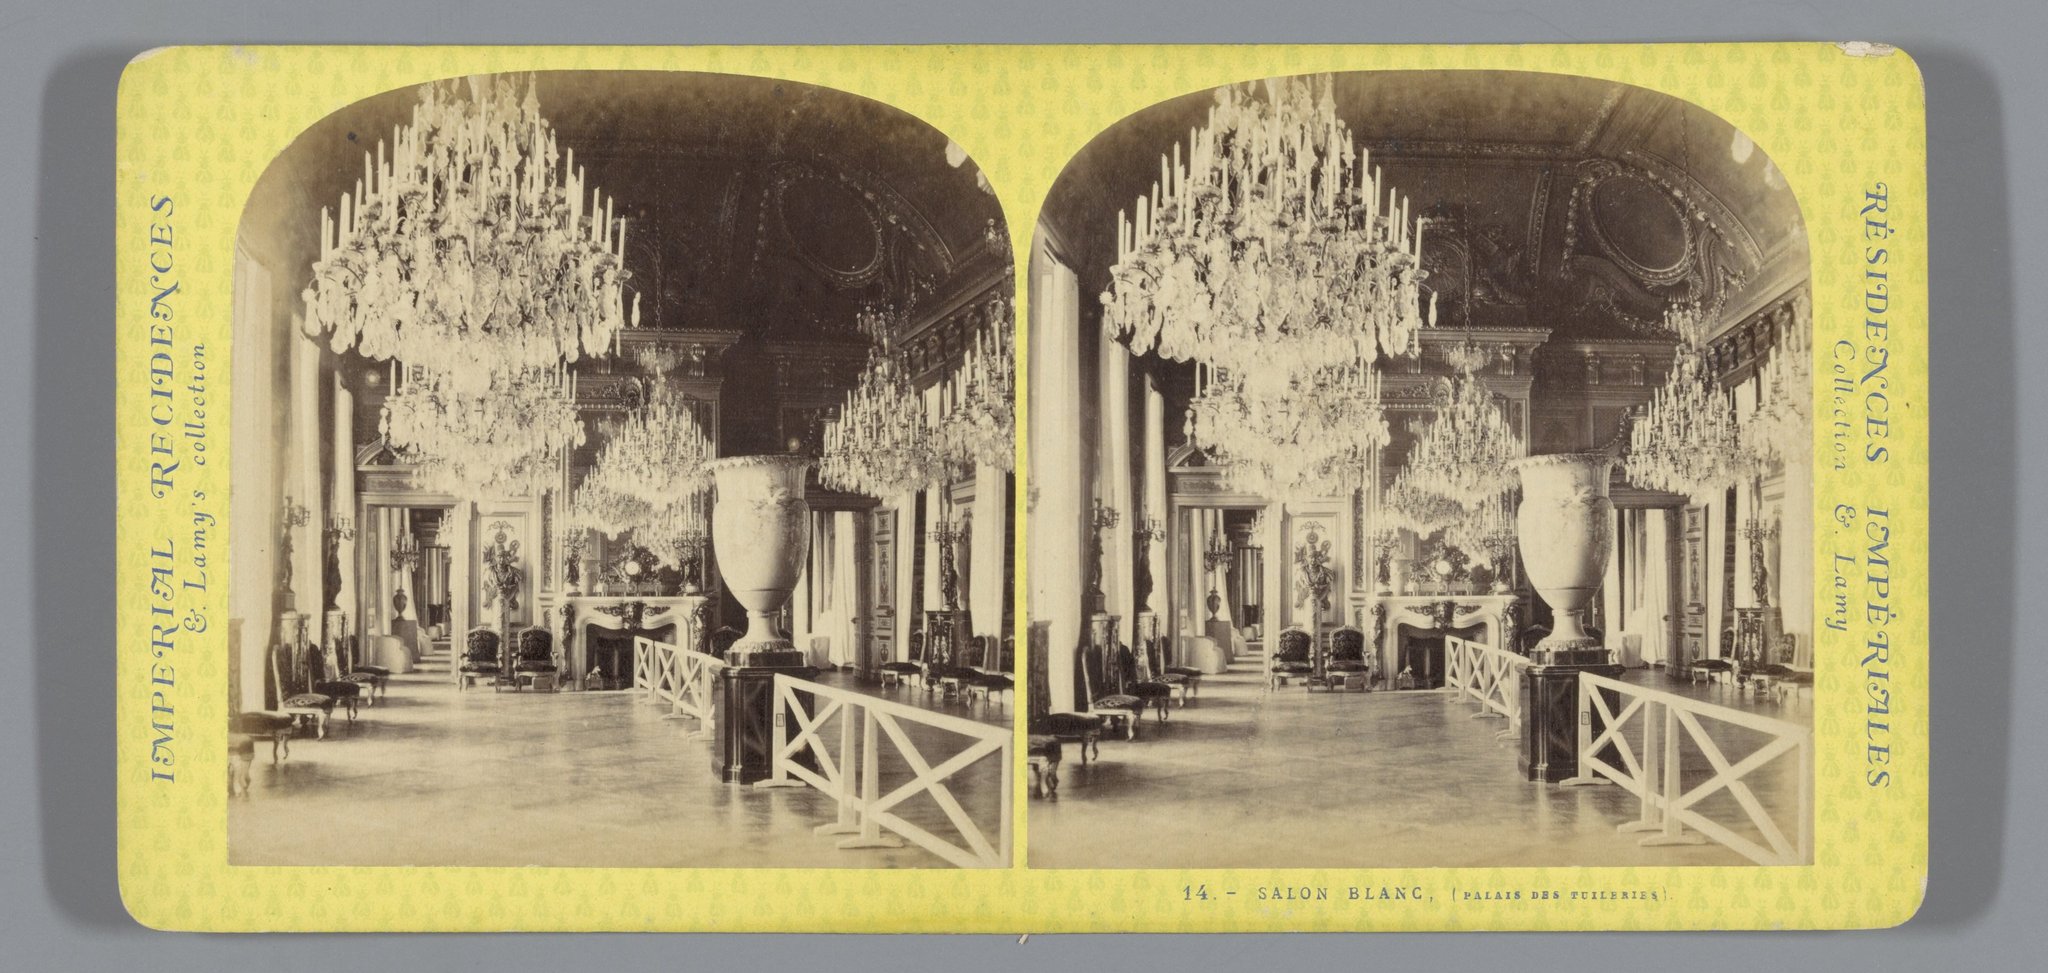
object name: stereograph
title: Imperial Residences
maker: ernest eléonor pierre lamy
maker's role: publisher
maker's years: 1828-1900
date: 1860-1871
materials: cardboard, photographic support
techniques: albumen print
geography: tuileries palace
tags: drawing-room, 'salon', palace, interior ~ representation of a building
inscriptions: number: ‘14.’, inscription: ‘E. Lamy's collection’